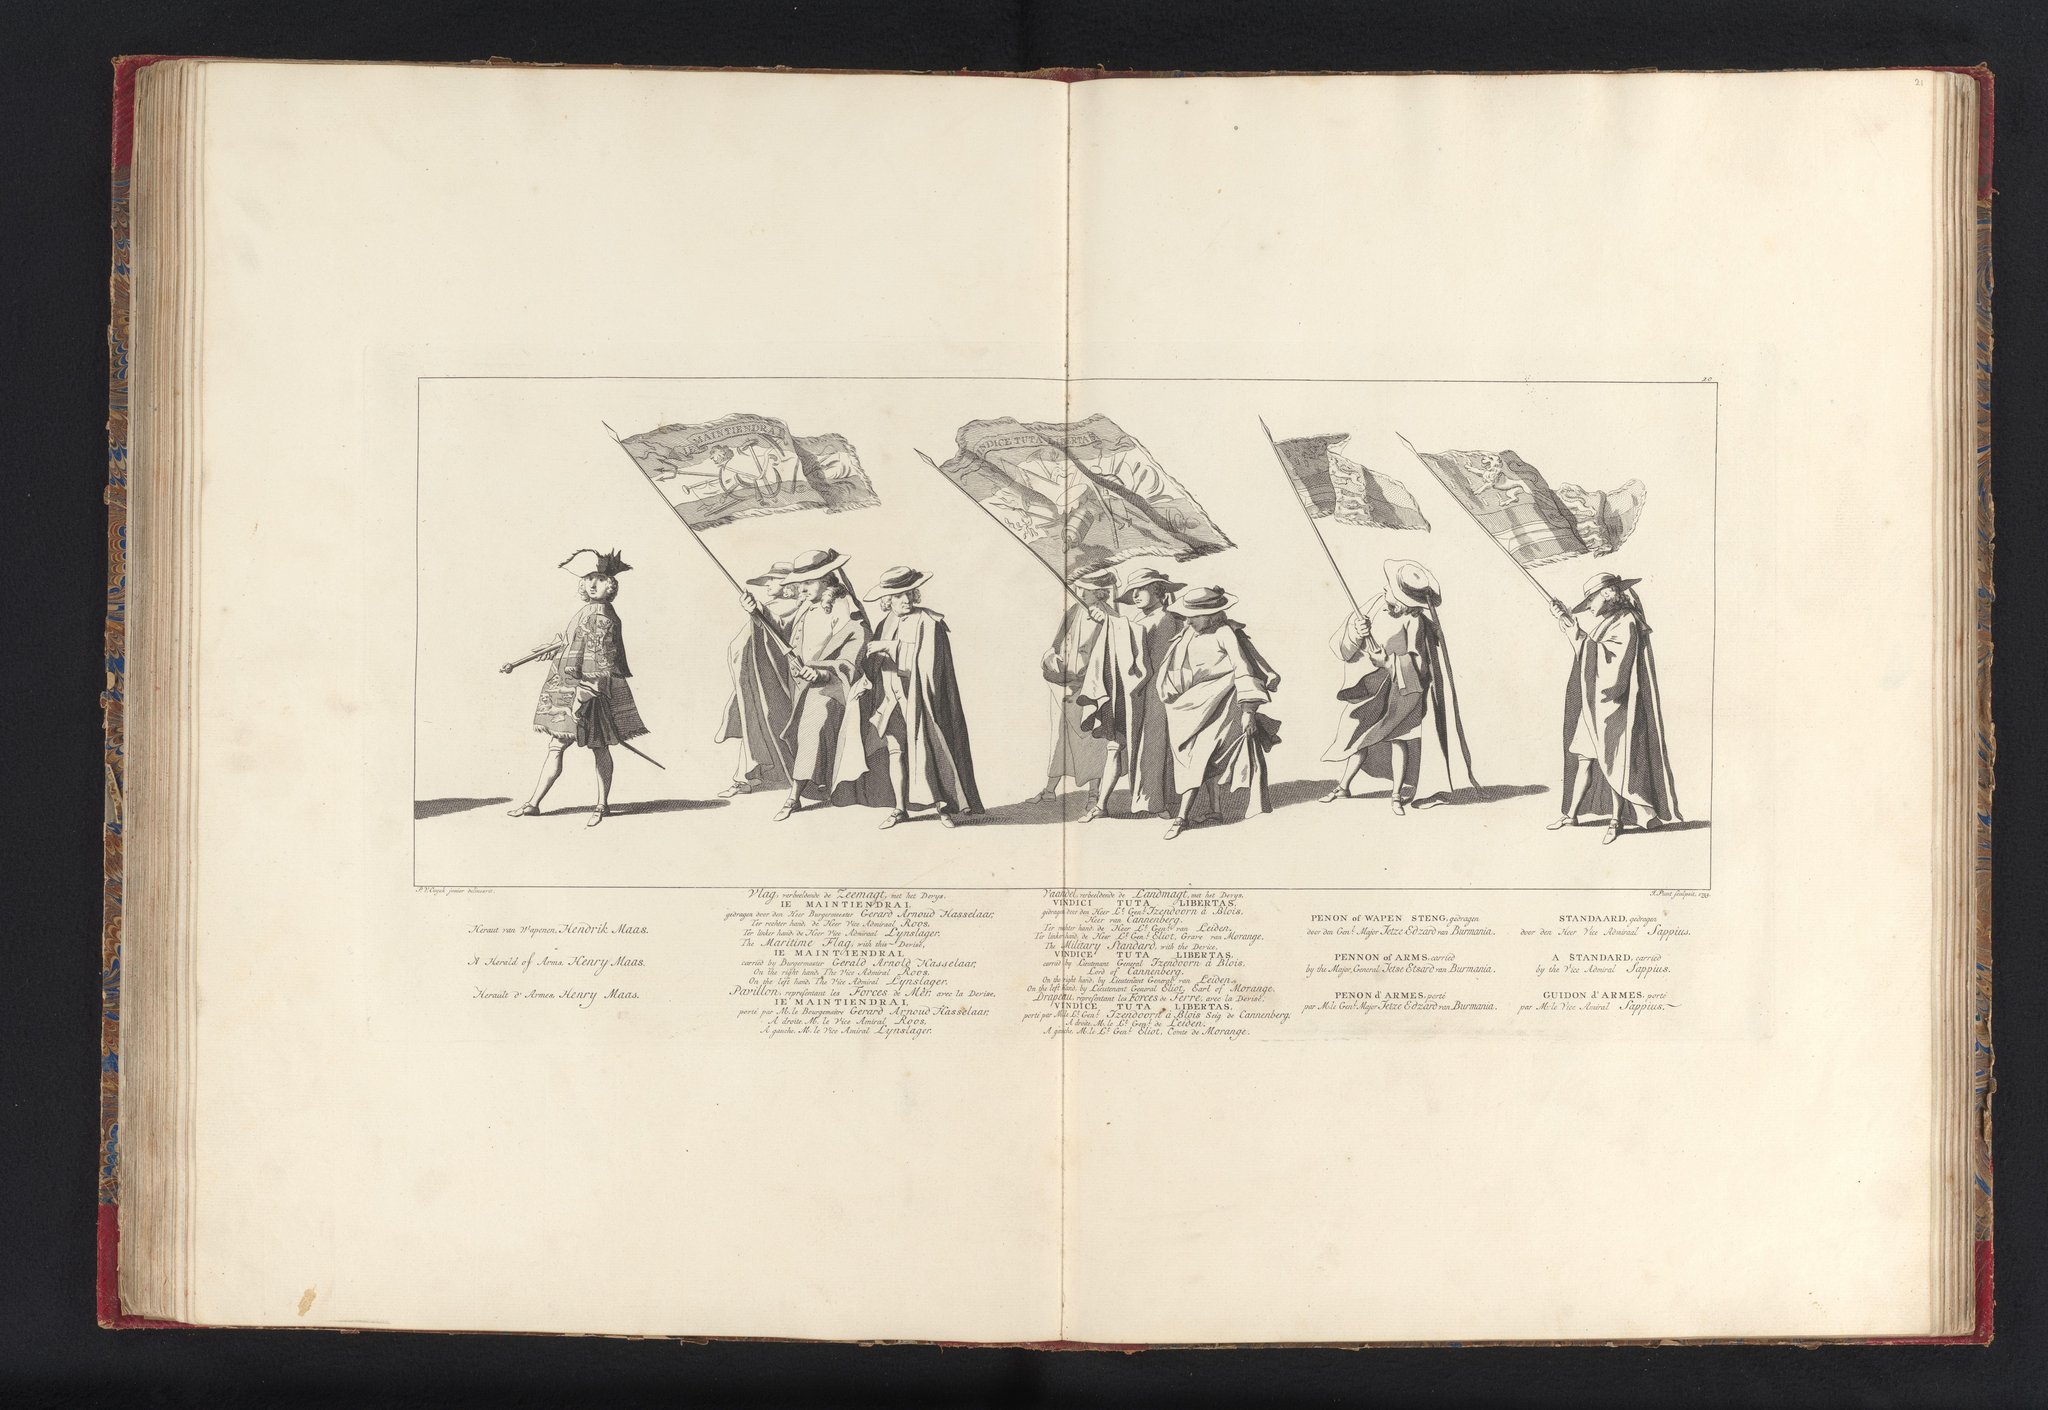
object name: album leaf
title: Lyk-staetsie van zyne doorluchtigste Hoogheid den Heere Willem Carel Hendrik Friso, Prince van Orange en Nassau (...) gehouden den IV Februari 1752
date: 1753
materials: paper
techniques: engraving, etching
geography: the hague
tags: the hague, willem iv (prins van oranje-nassau), cortege, funeral procession, insignia and symbols of sovereignty (crown, diadem, sceptre, orb, seal, standard, cloak, pectoral), delft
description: Heraut gevolgd door de dragers van vaandels van de zeemacht en landmacht. In de marge een onderschrift in het Nederlands, Frans en Engels. De prent maakt deel uit van een album.